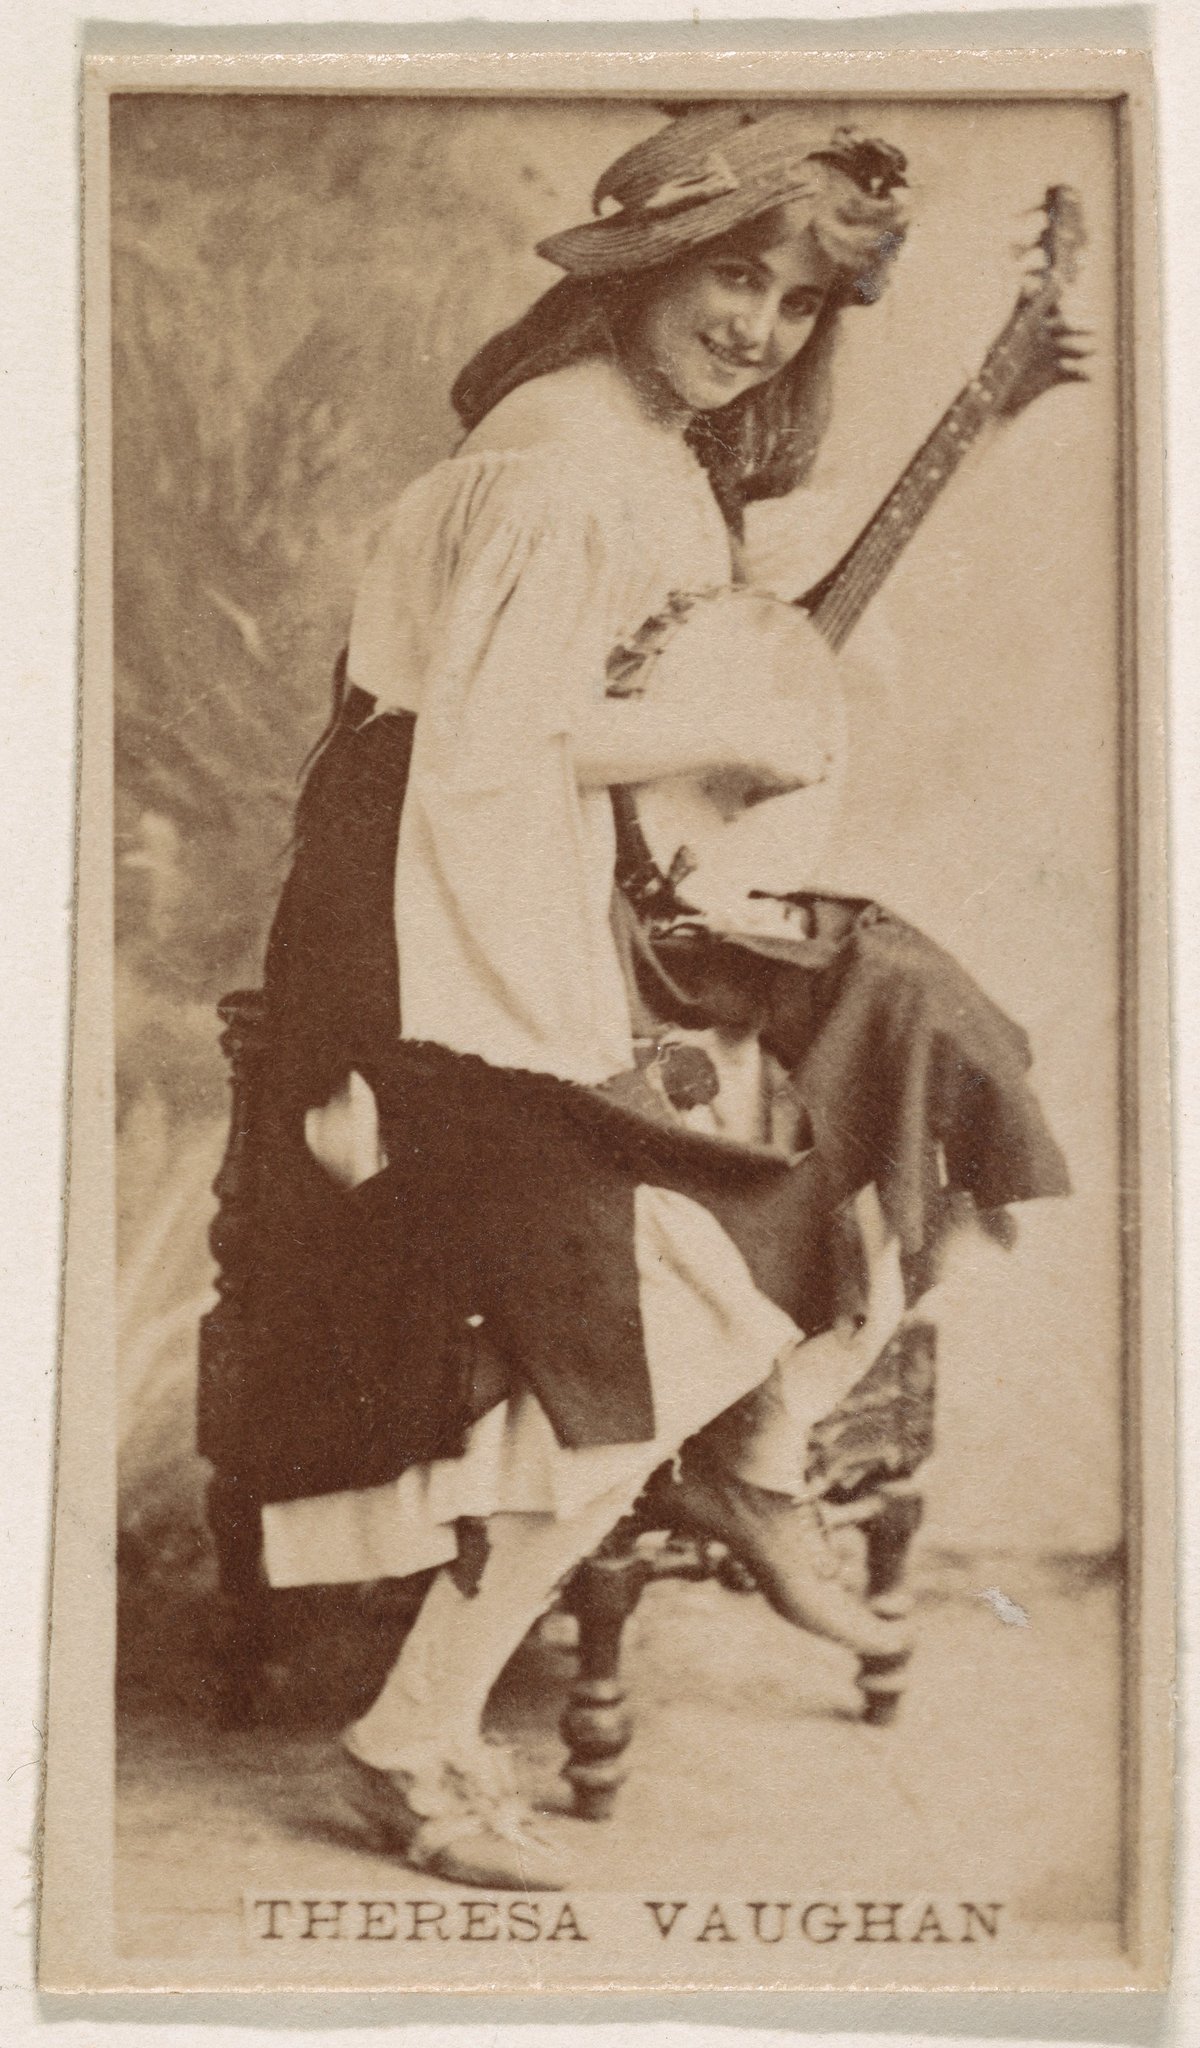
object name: photograph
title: Theresa Vaughn, from the Actresses series (N245) issued by Kinney Brothers to promote Sweet Caporal Cigarettes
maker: kinney brothers tobacco company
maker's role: publisher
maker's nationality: american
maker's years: 1869-2011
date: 1890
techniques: albumen silver print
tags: musical instruments,portraits,women,actresses